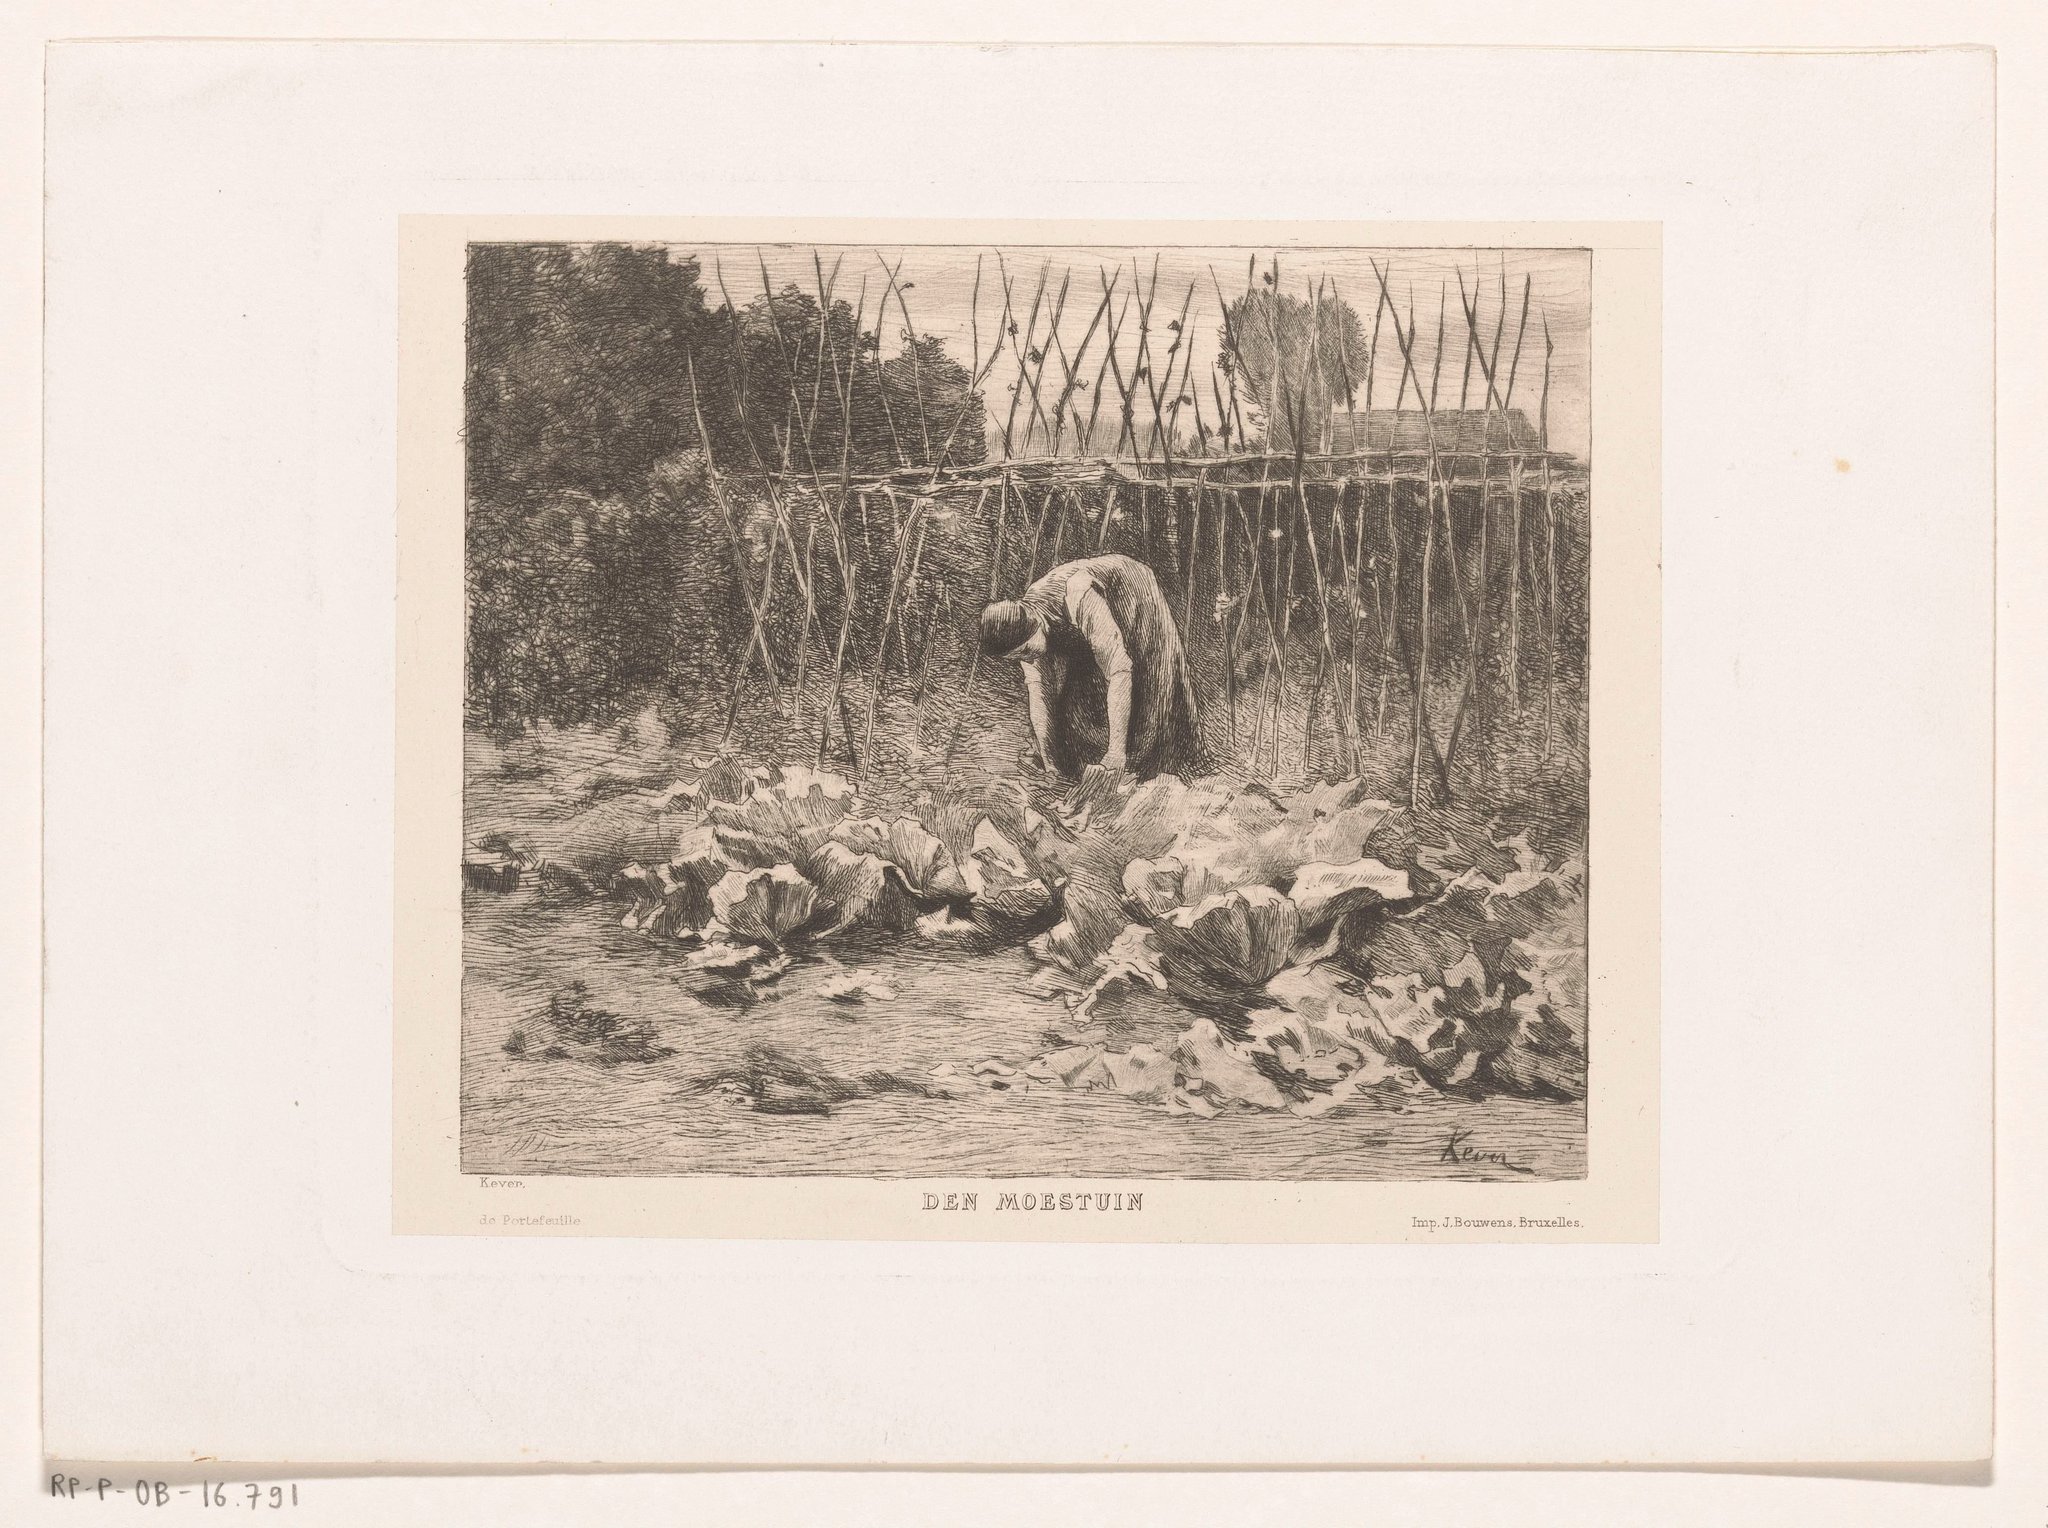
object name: print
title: Den moestuin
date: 1864-1922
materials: paper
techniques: etching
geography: brussels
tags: nursery, market garden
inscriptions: collector's mark: Lugt 2228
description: Een vrouw aan het werk in een moestuin met bonenranken.